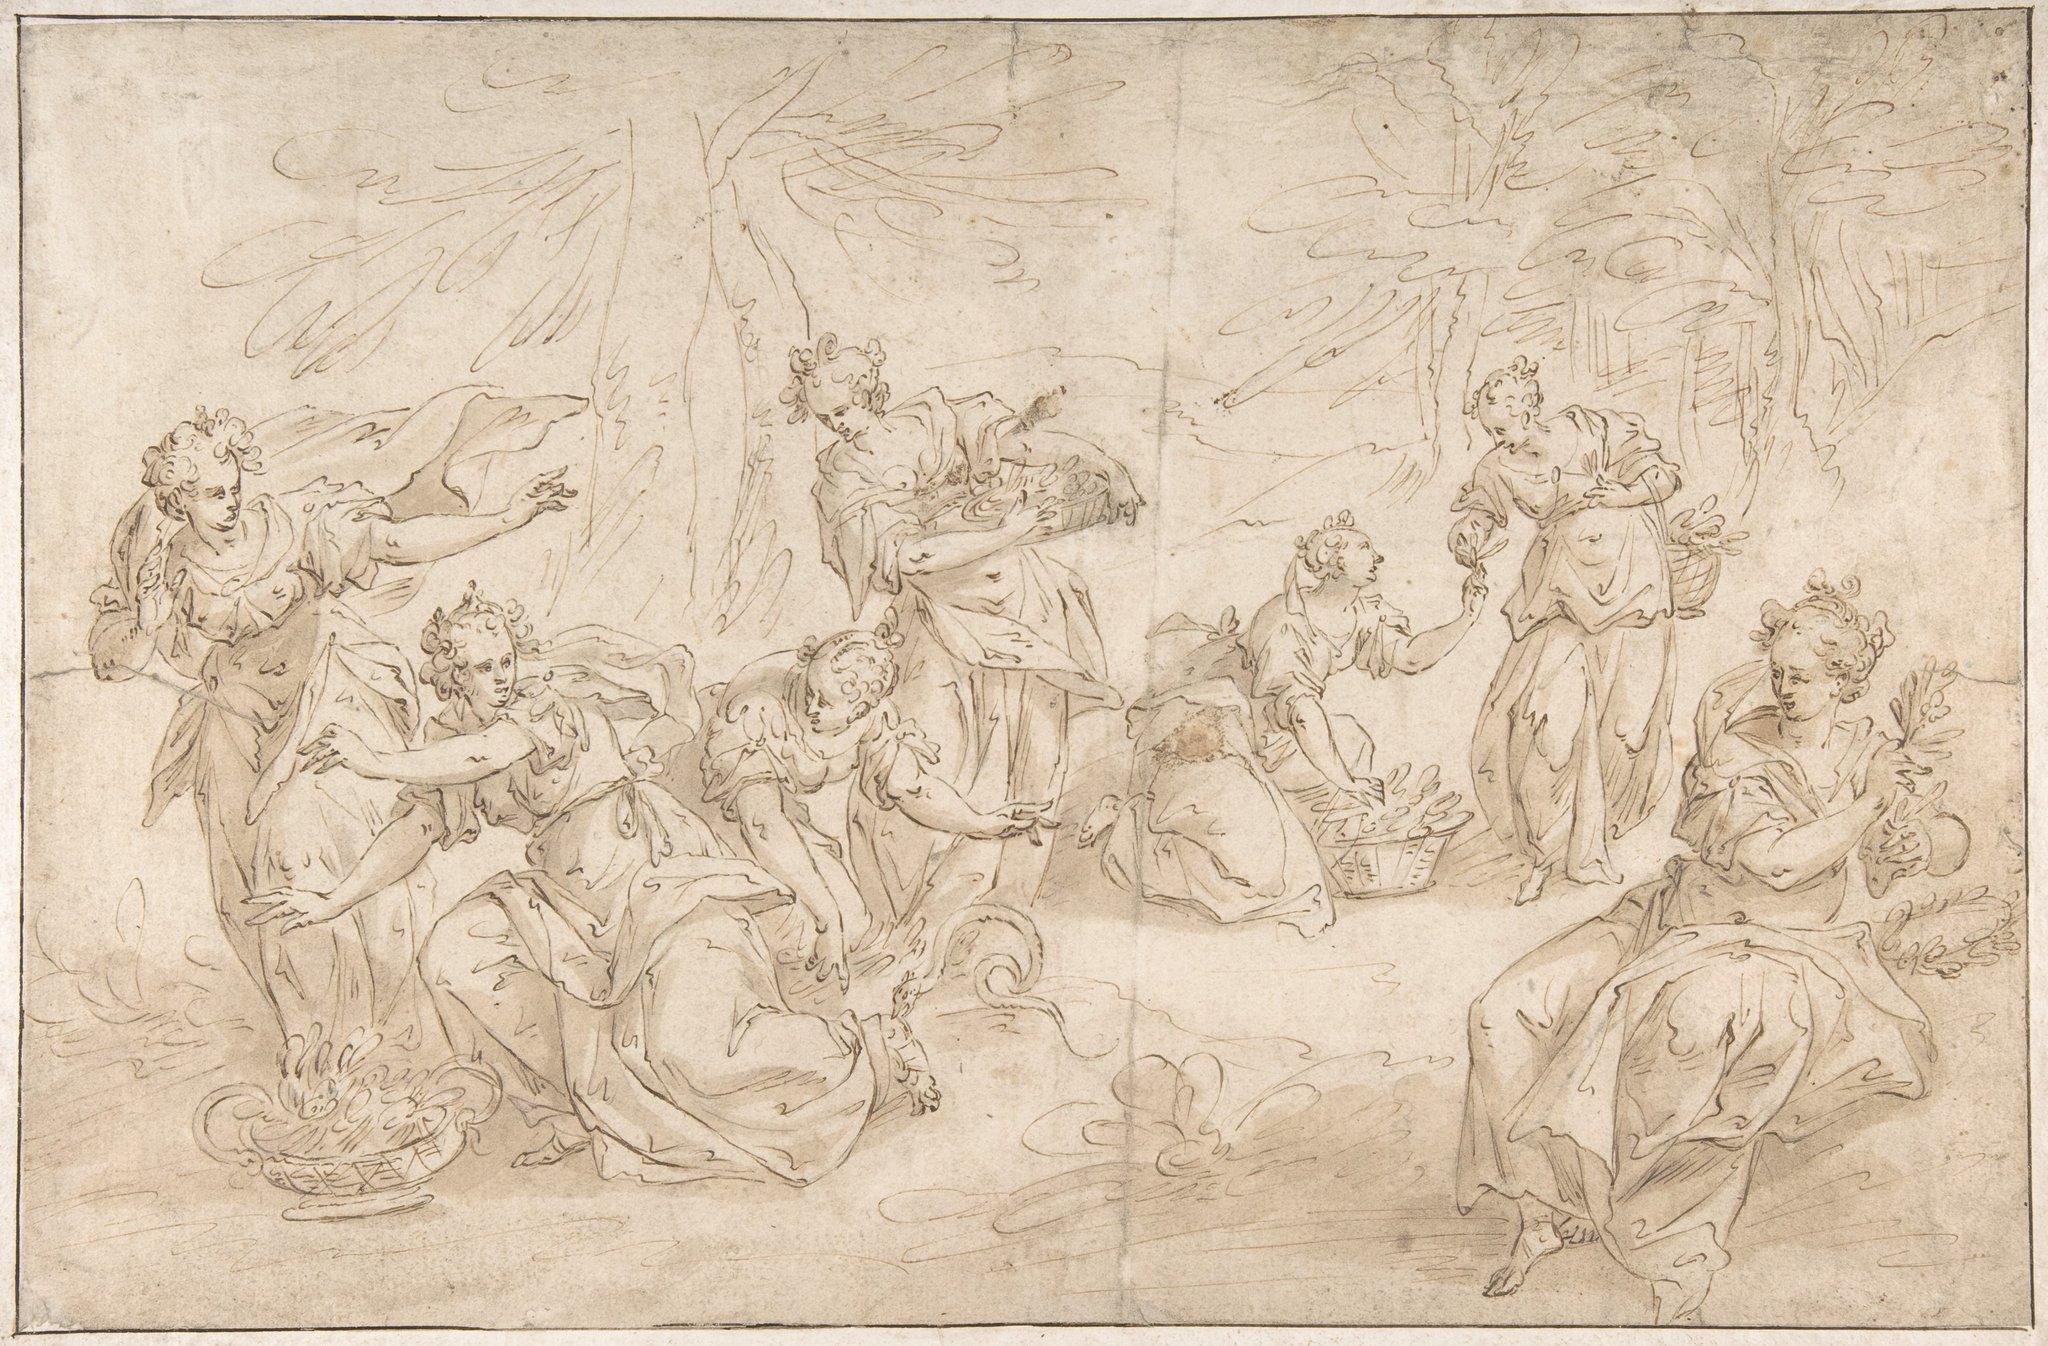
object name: drawing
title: Eurydice Bitten by a Serpent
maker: hendrick de clerck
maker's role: artist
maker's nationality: netherlandish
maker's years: 1570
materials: chalk, ink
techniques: brush, pen, wash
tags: women,snakes,eurydice